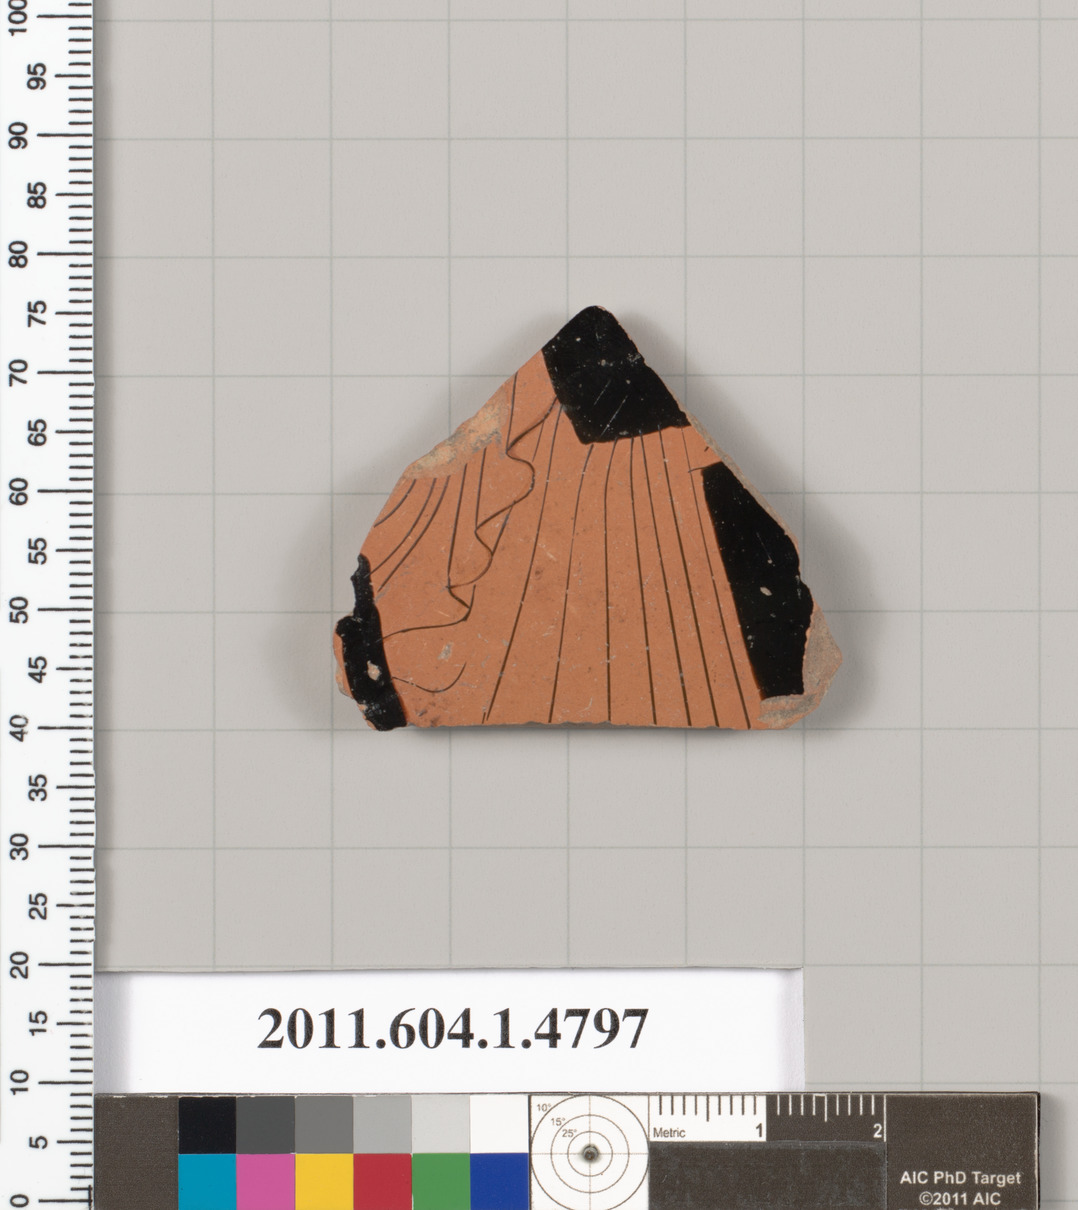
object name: kylix fragment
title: Terracotta fragment of a kylix (drinking cup)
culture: greek, attic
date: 475-451 BCE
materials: terracotta